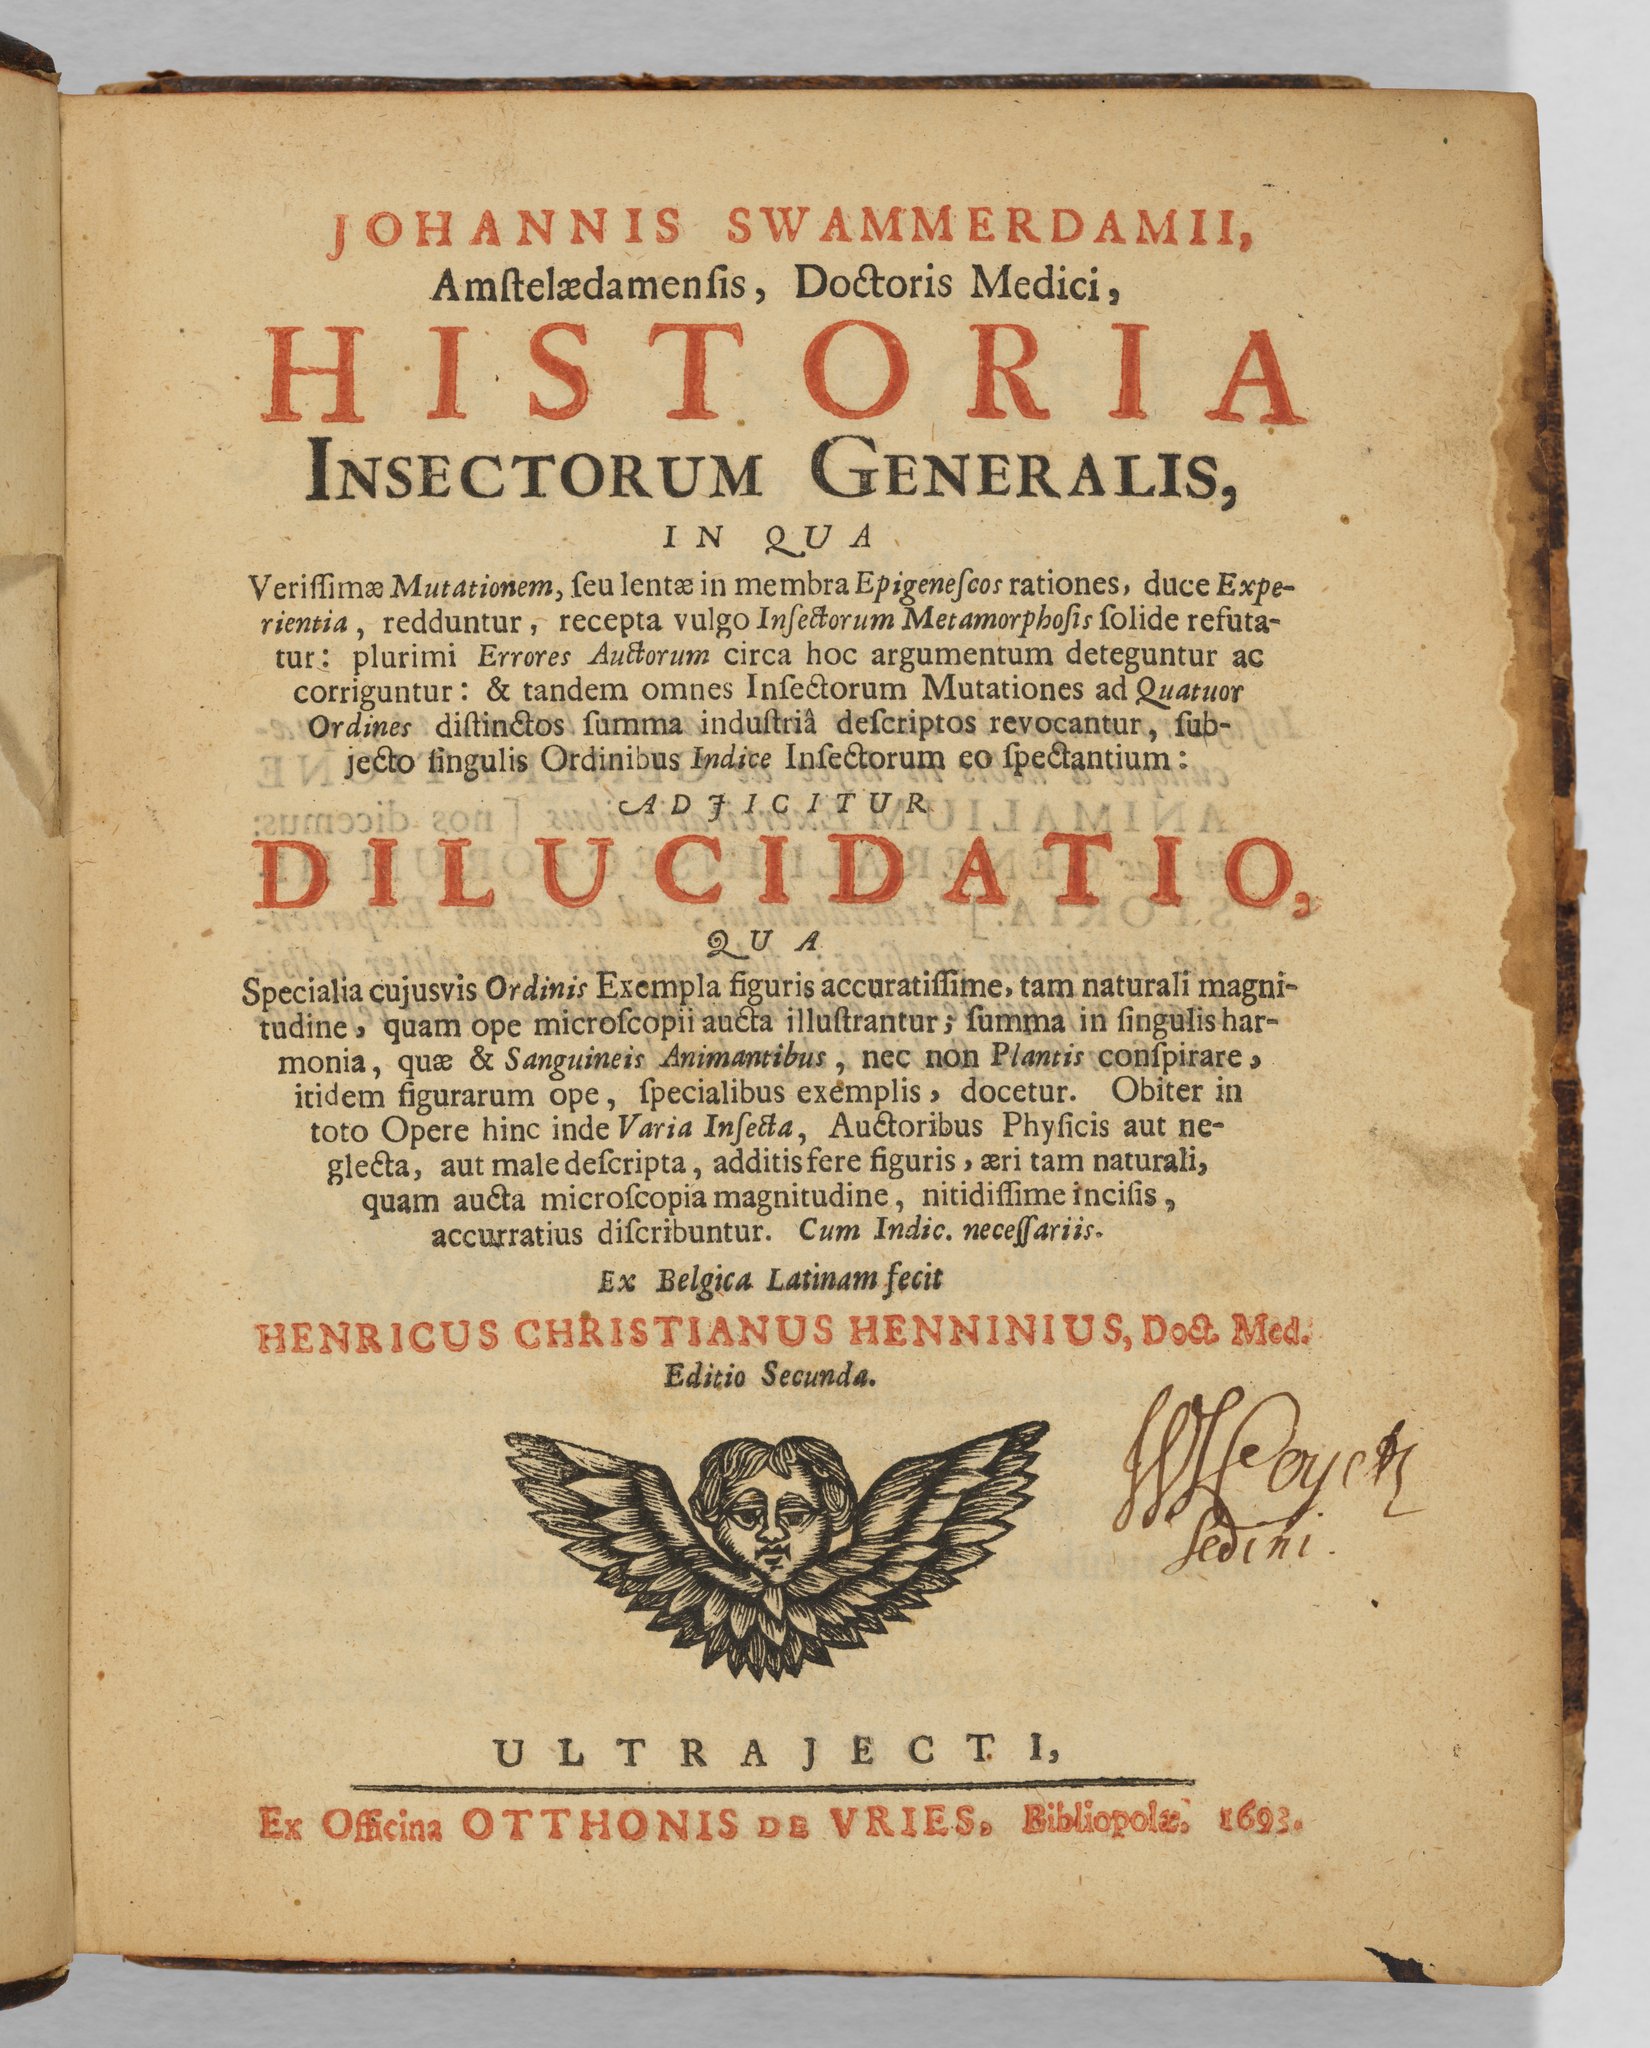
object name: book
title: Historia Insectorum Generalis...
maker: john swammerdam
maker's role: author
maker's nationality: netherlandish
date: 1693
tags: insects